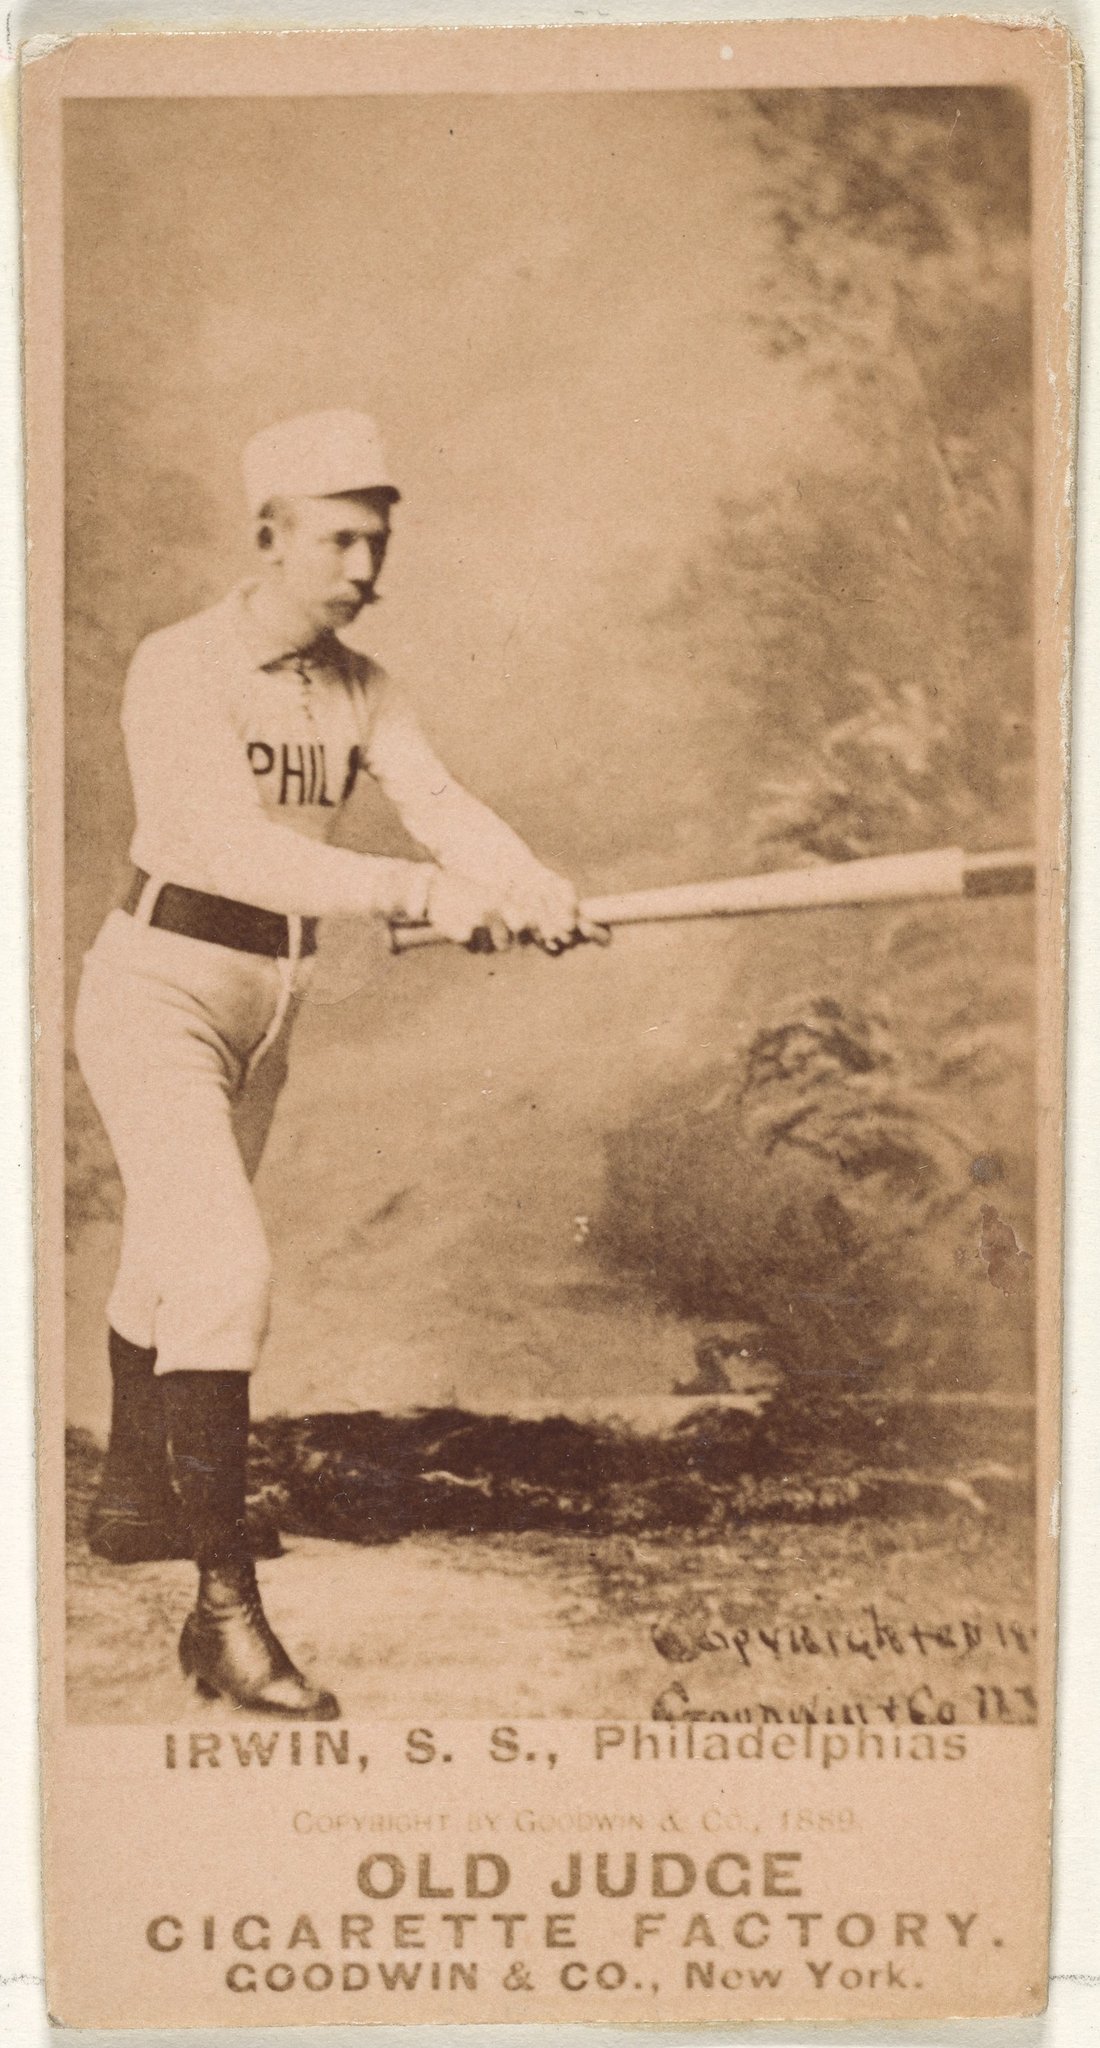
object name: baseball card, photograph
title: Arthur Albert "Doc" Irwin, Shortstop, Philadelphia, from the Old Judge series (N172) for Old Judge Cigarettes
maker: goodwin & company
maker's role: publisher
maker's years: 1850-1950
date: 1889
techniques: albumen silver print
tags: men,portraits,baseball,athletes